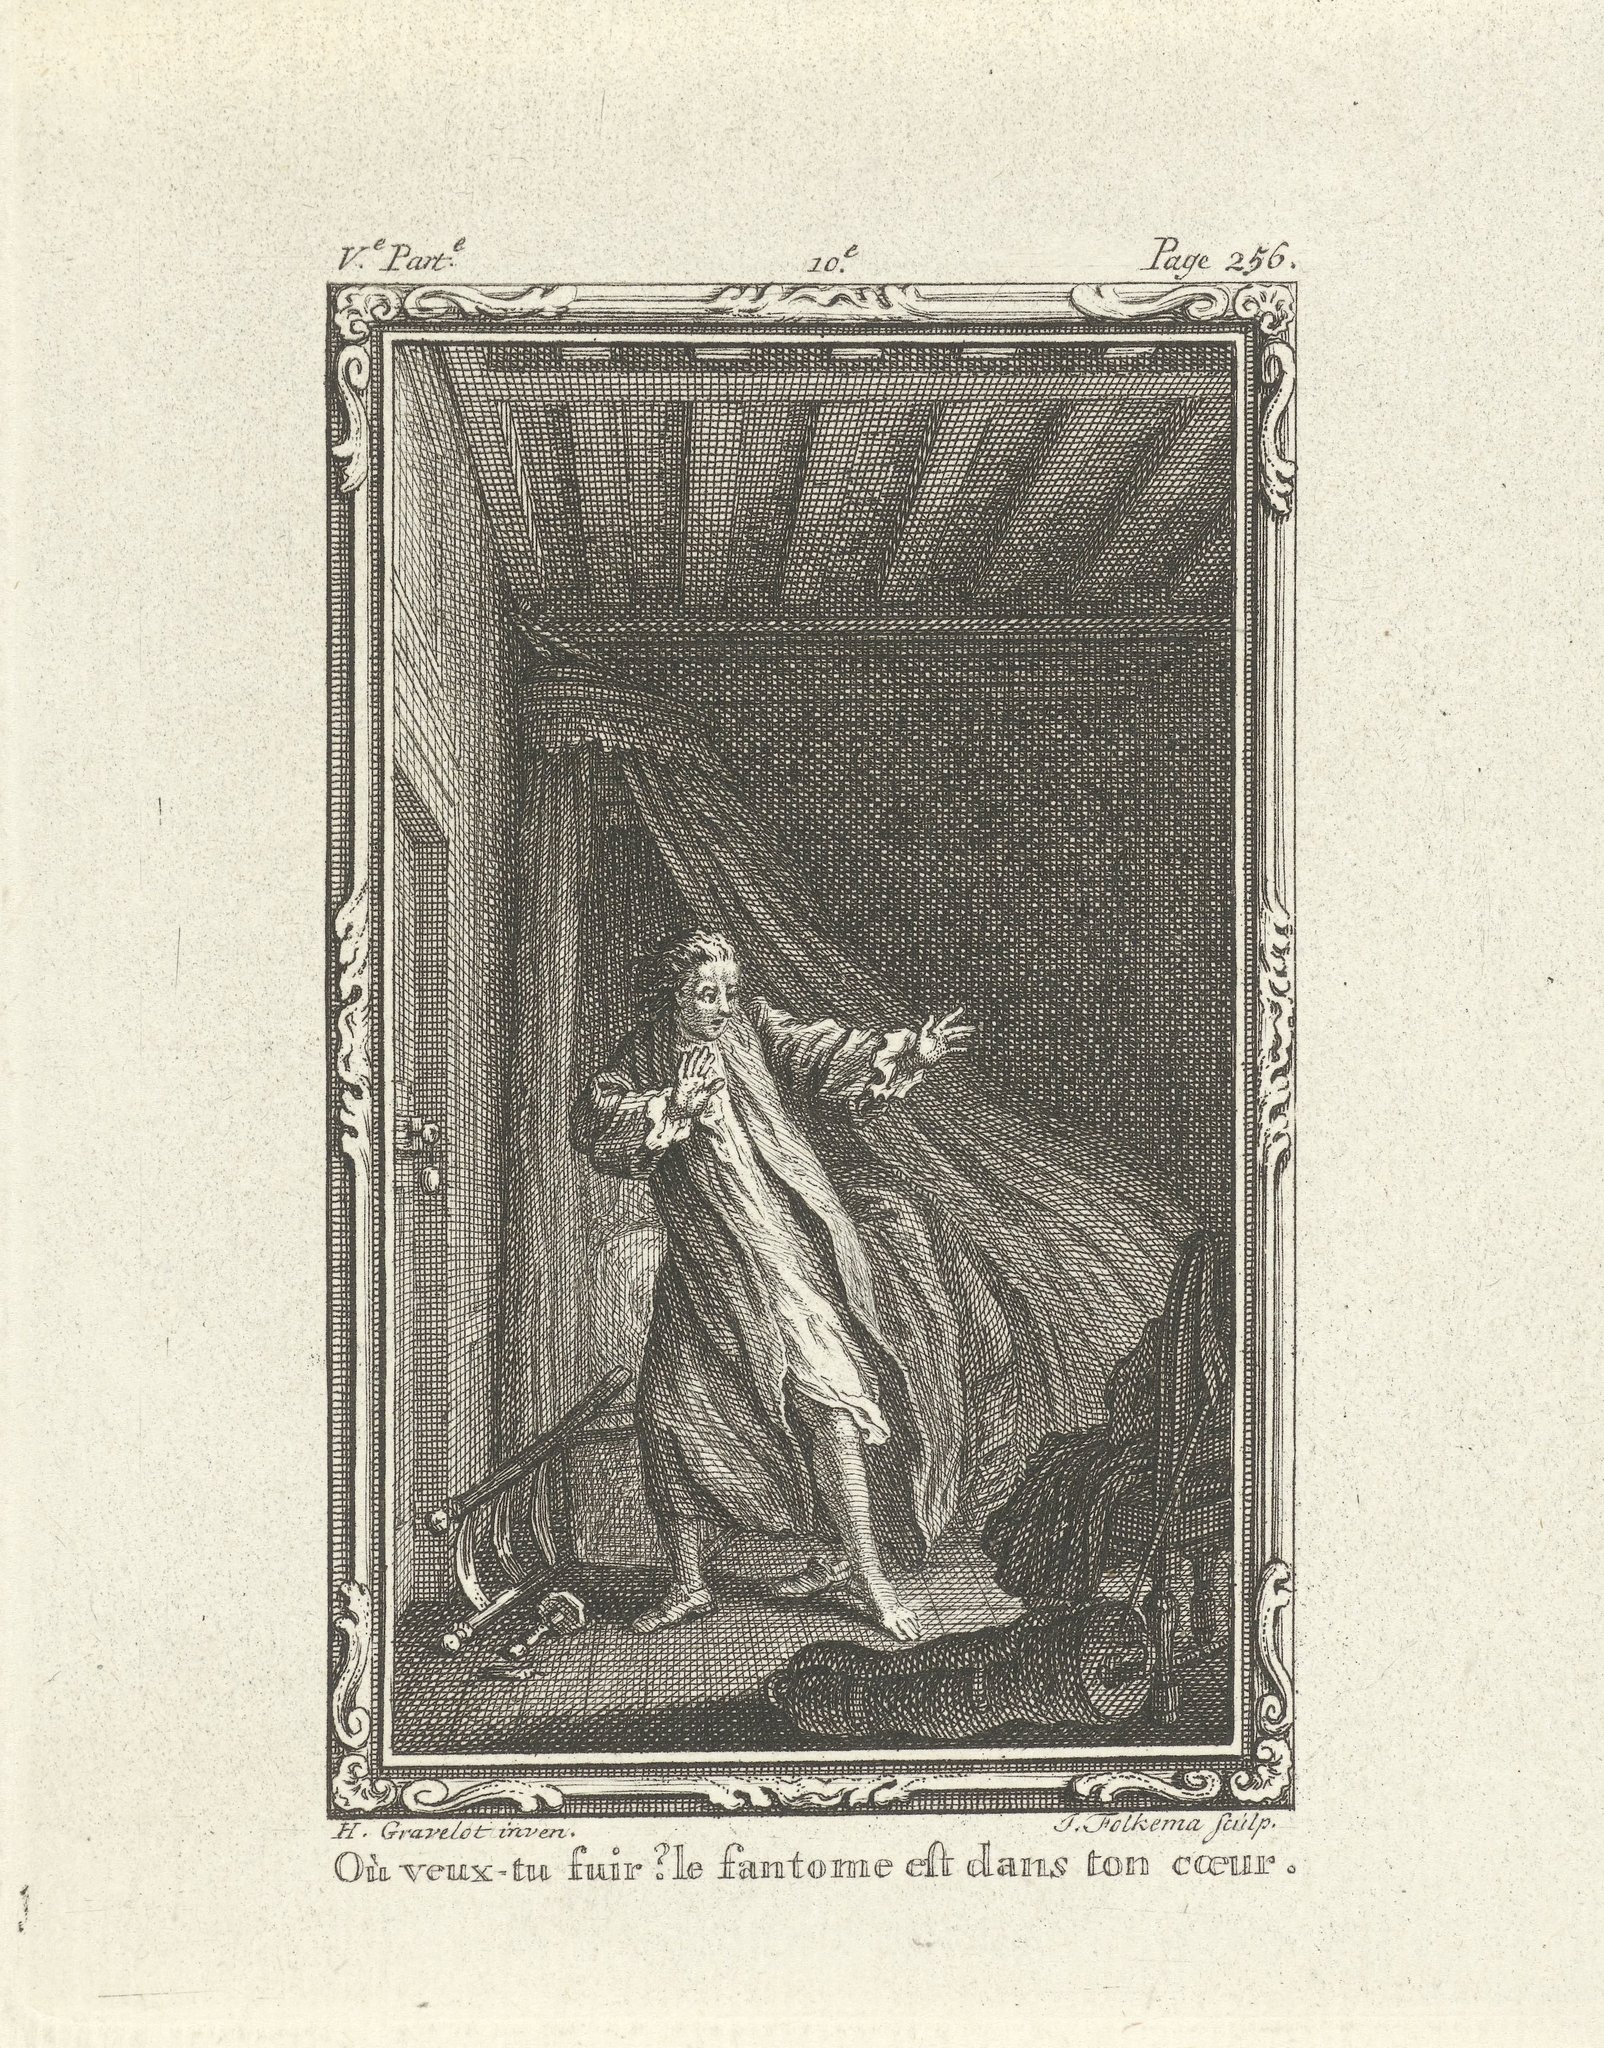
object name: print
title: Geschrokken man in een slaapkamer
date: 1761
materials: paper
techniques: etching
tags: bedroom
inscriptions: collector's mark: Lugt 2228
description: Een man staat in nachtkleding naast zijn bed. Met geheven handen kijkt hij verschrikt om zich heen. Links naast hem ligt een omgevallen stoel en kaars. Onder de voorstelling staat een eenregelig onderschrift in het Frans. Prent links- en rechtsboven gemerkt: Ve. Part - Page 256.